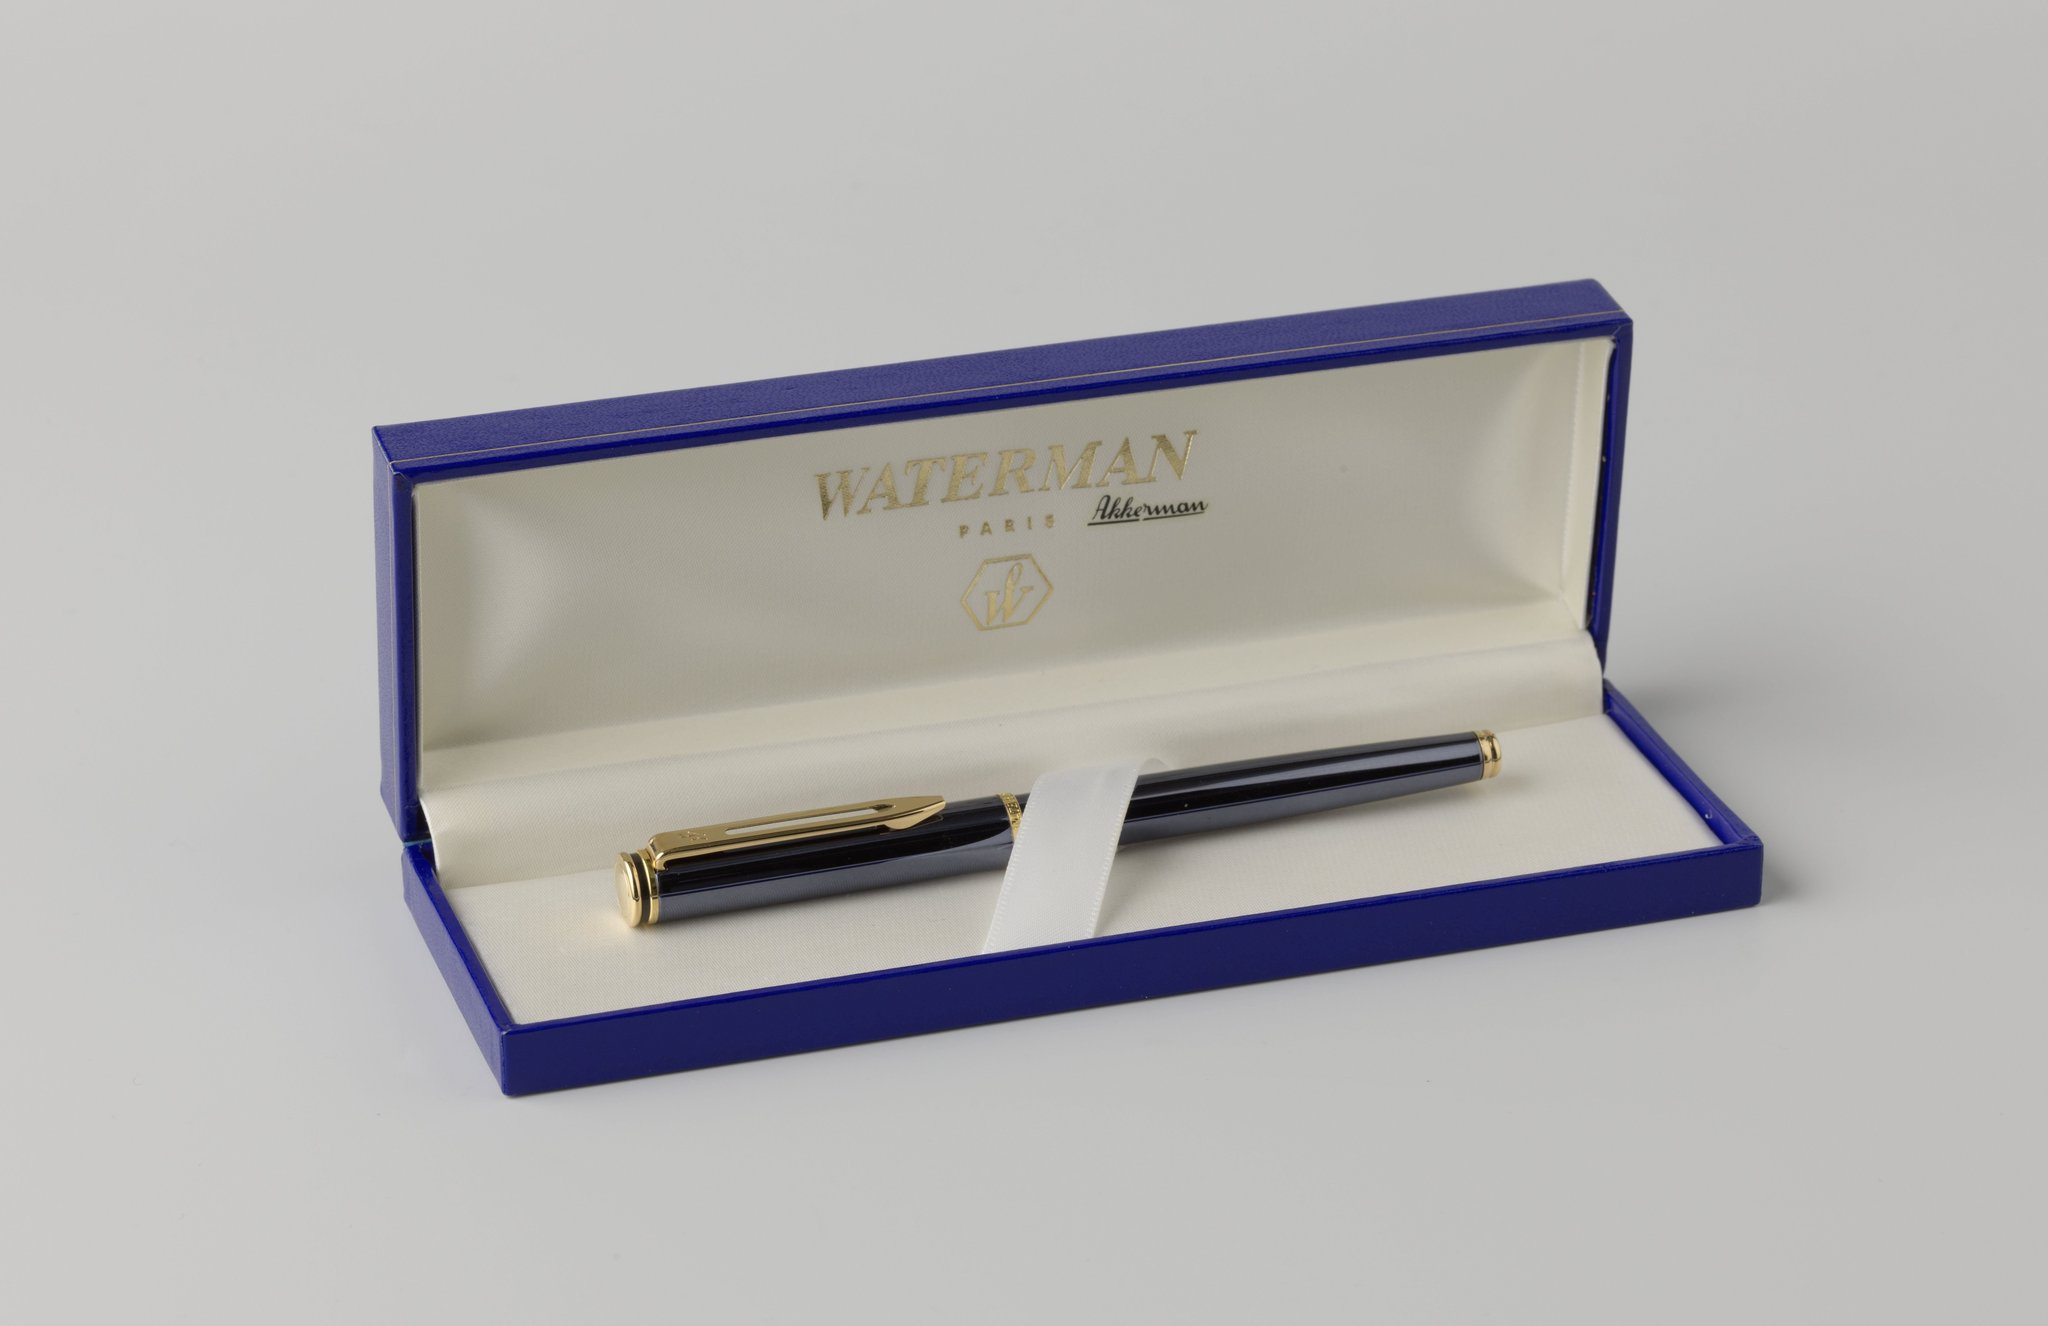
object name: pennendoos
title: Pennendoos behorende bij de pen die gebruikt is bij het ondertekenen van de protocollen van overdracht bij de verzelfstandiging van het Rijksmuseum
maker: waterman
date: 1995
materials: alloy, cardboard, plastic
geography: france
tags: rijksmuseum amsterdam, amsterdam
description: Een paarse pennendoos met witte voering. De opschriften op de doos zijn goudkleurig.